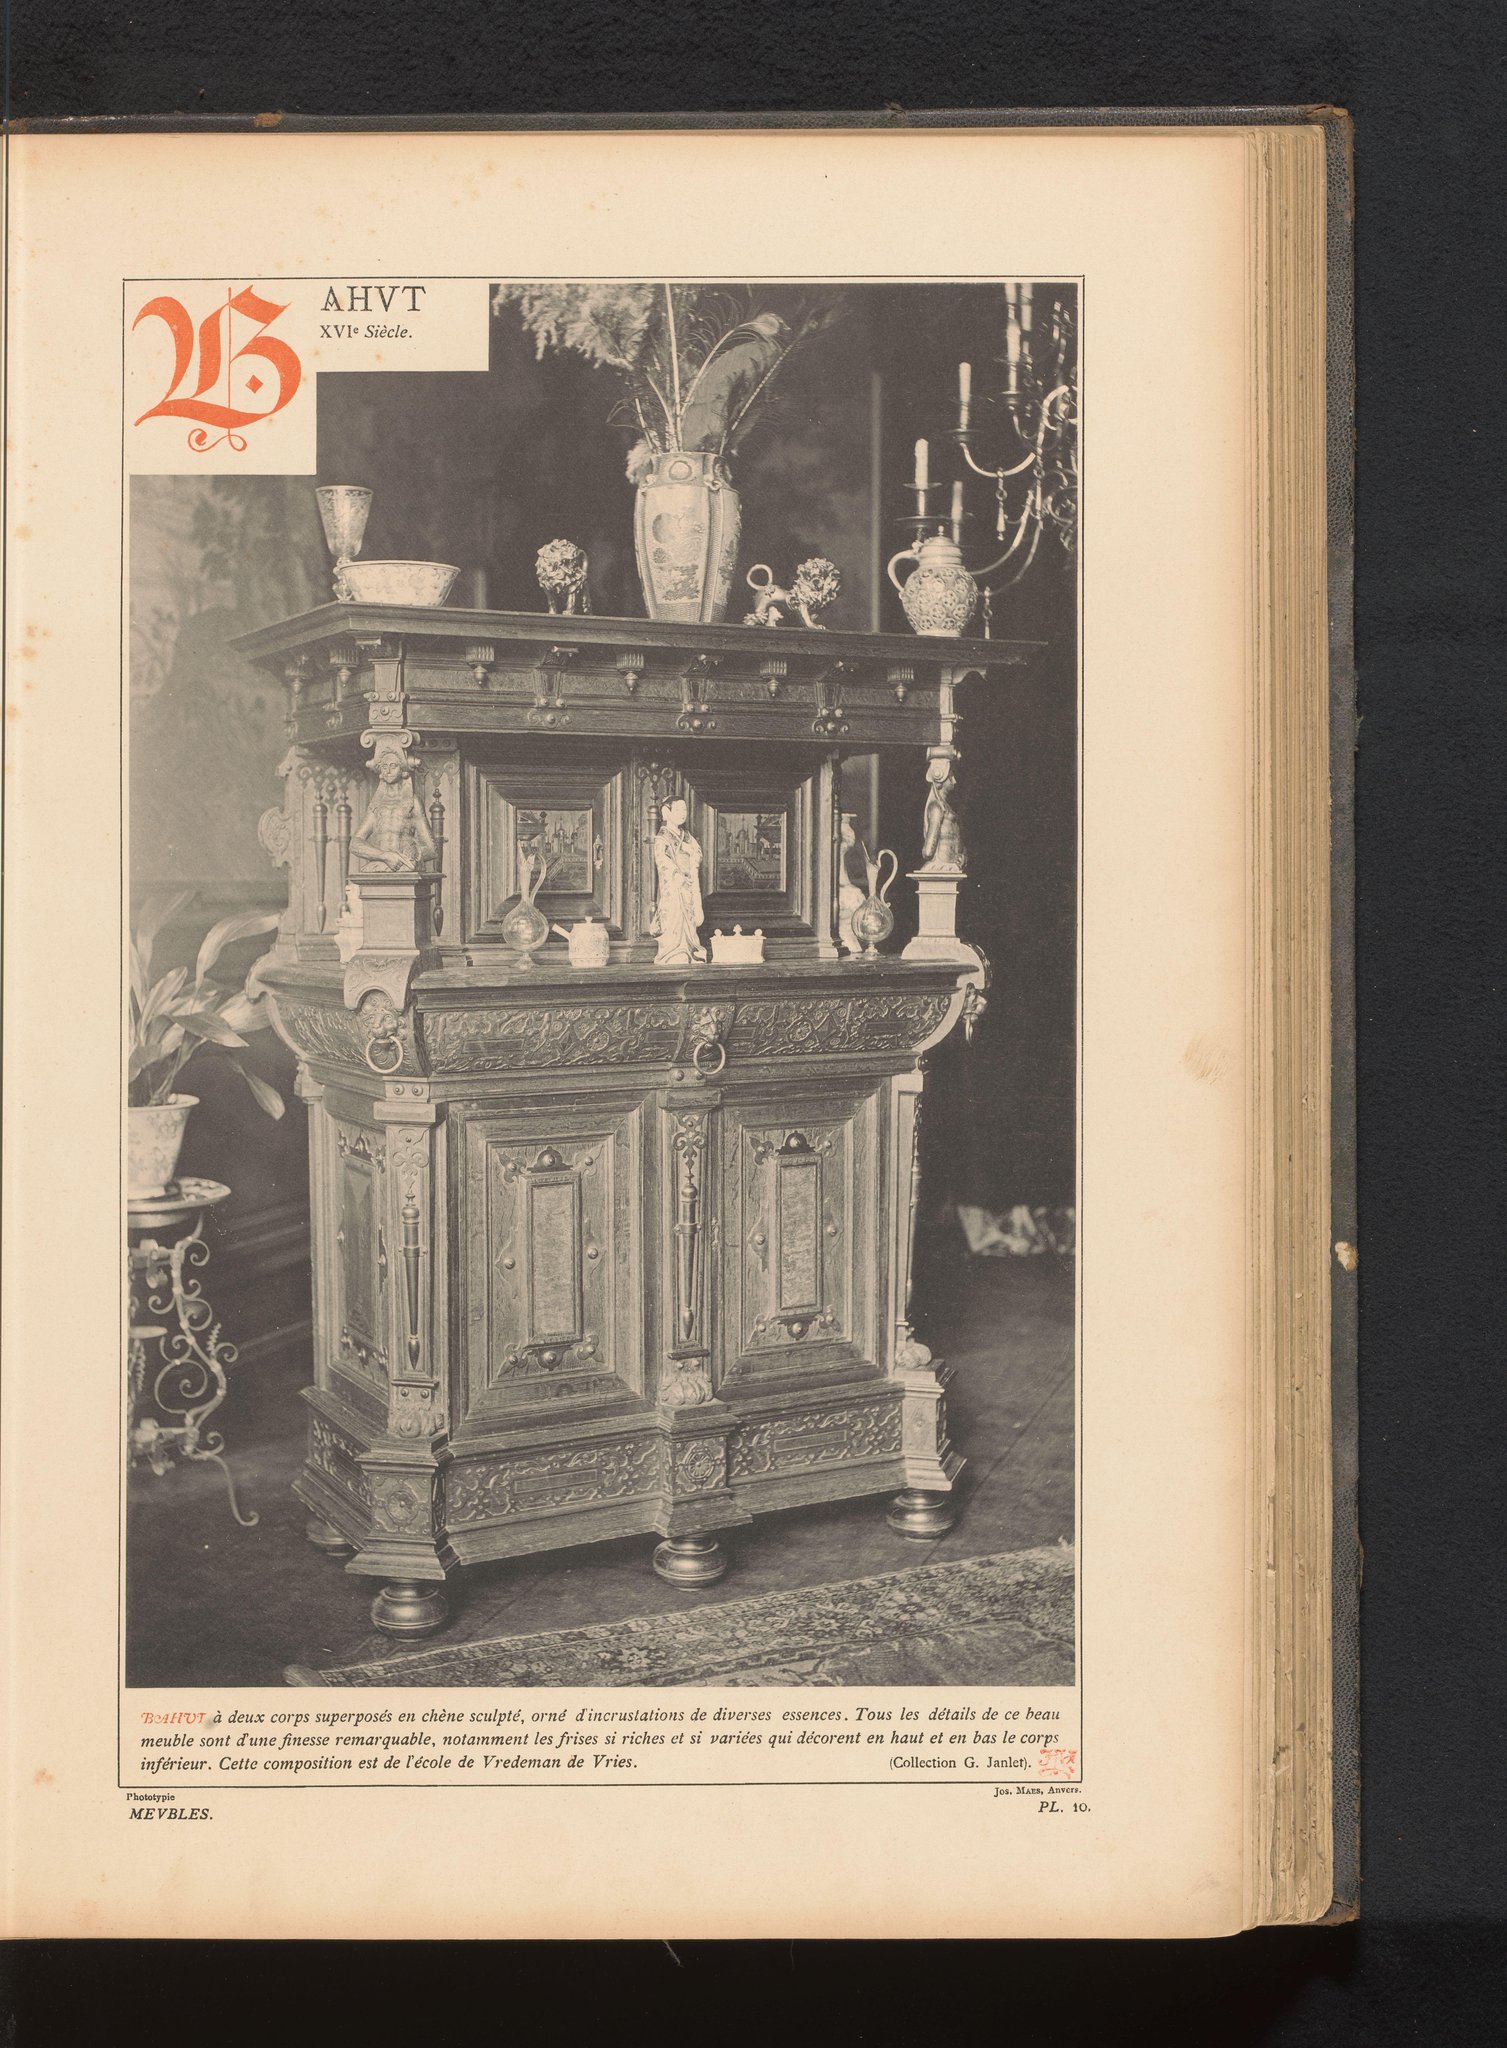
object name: photomechanical print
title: Eikenhouten kast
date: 1881-1889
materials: paper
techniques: photograph, photolithography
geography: antwerp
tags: furniture to put things on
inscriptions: inscription: ‘MEUBLES. PL. 10.’, monogram: ‘JJvY’, inscription: ‘BAHUT à deux (...)’